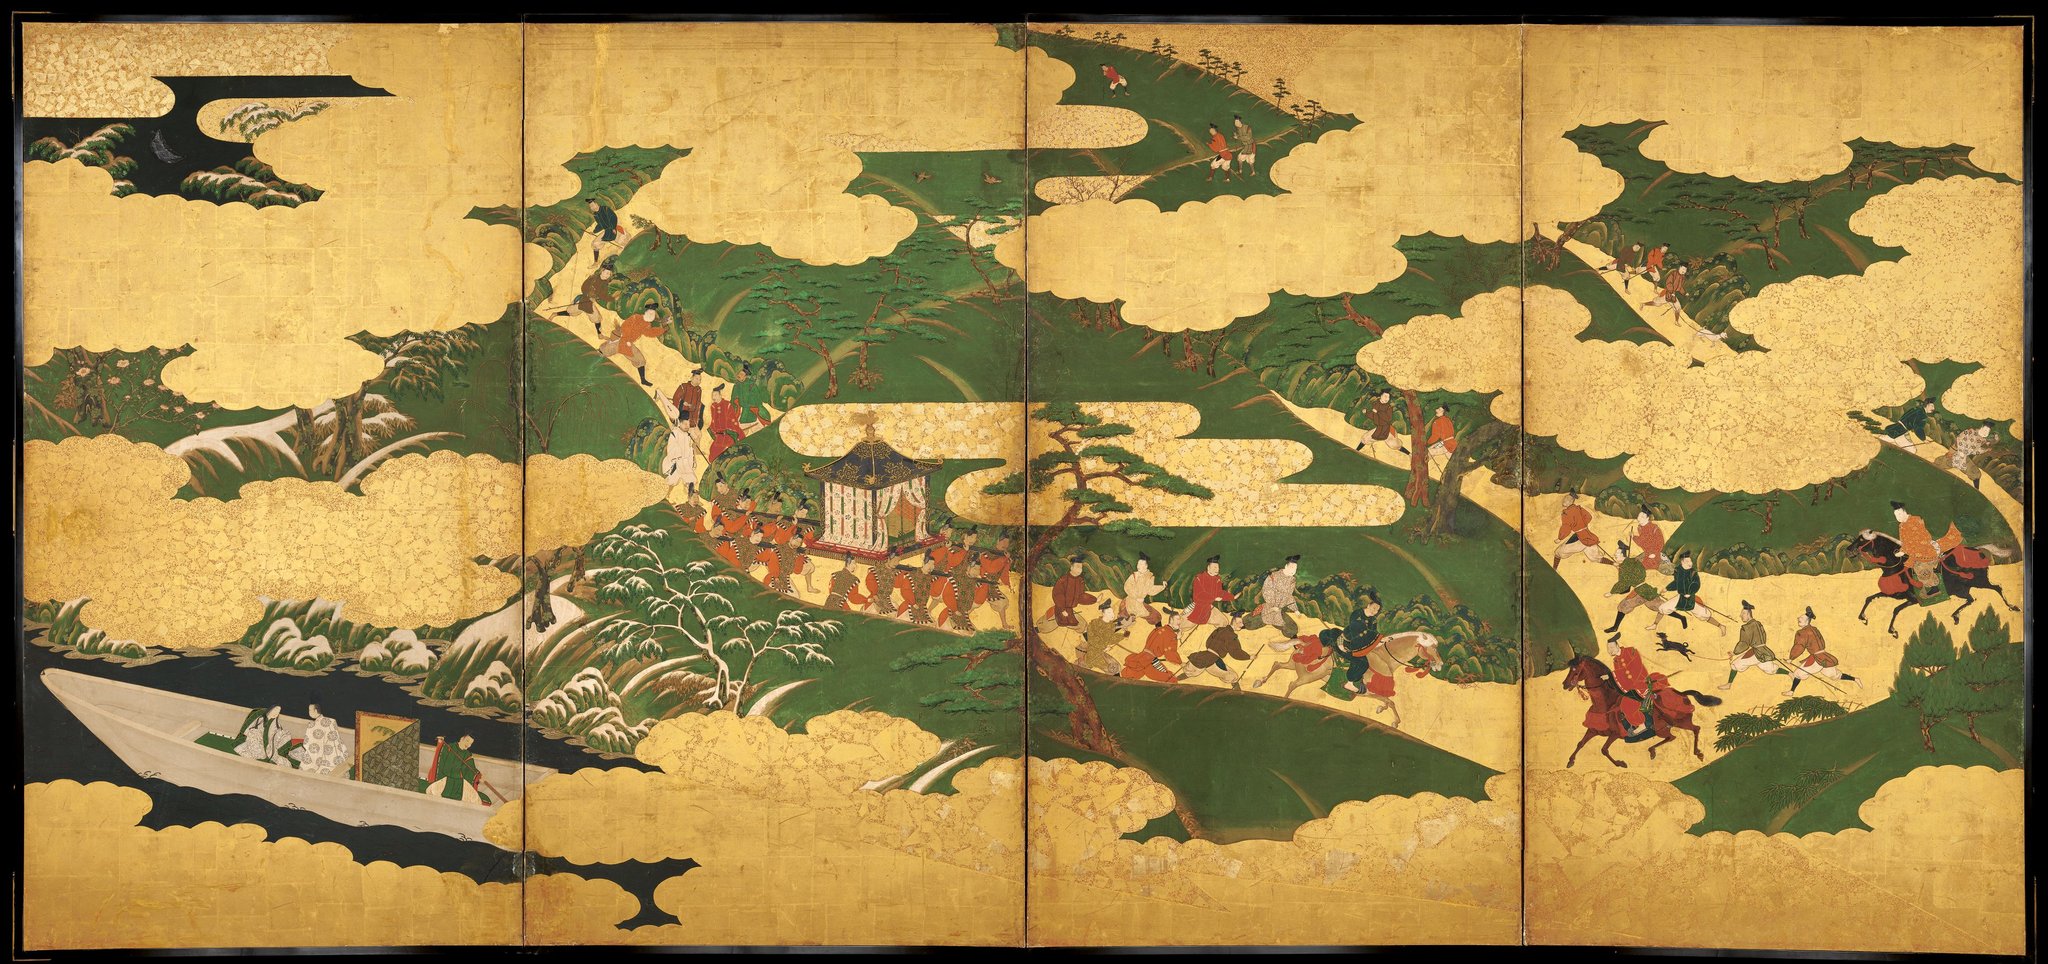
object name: screen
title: “An Imperial Excursion” (Miyuki), “A Boat Cast Adrift” (Ukifune), and “The Barrier Gate” (Sekiya)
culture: japanese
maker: tosa mitsuyoshi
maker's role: artist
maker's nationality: japanese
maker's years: 1539-1613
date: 1534-1633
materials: gold leaf, ink, panel, paper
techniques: painting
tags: men,women,horses,boats